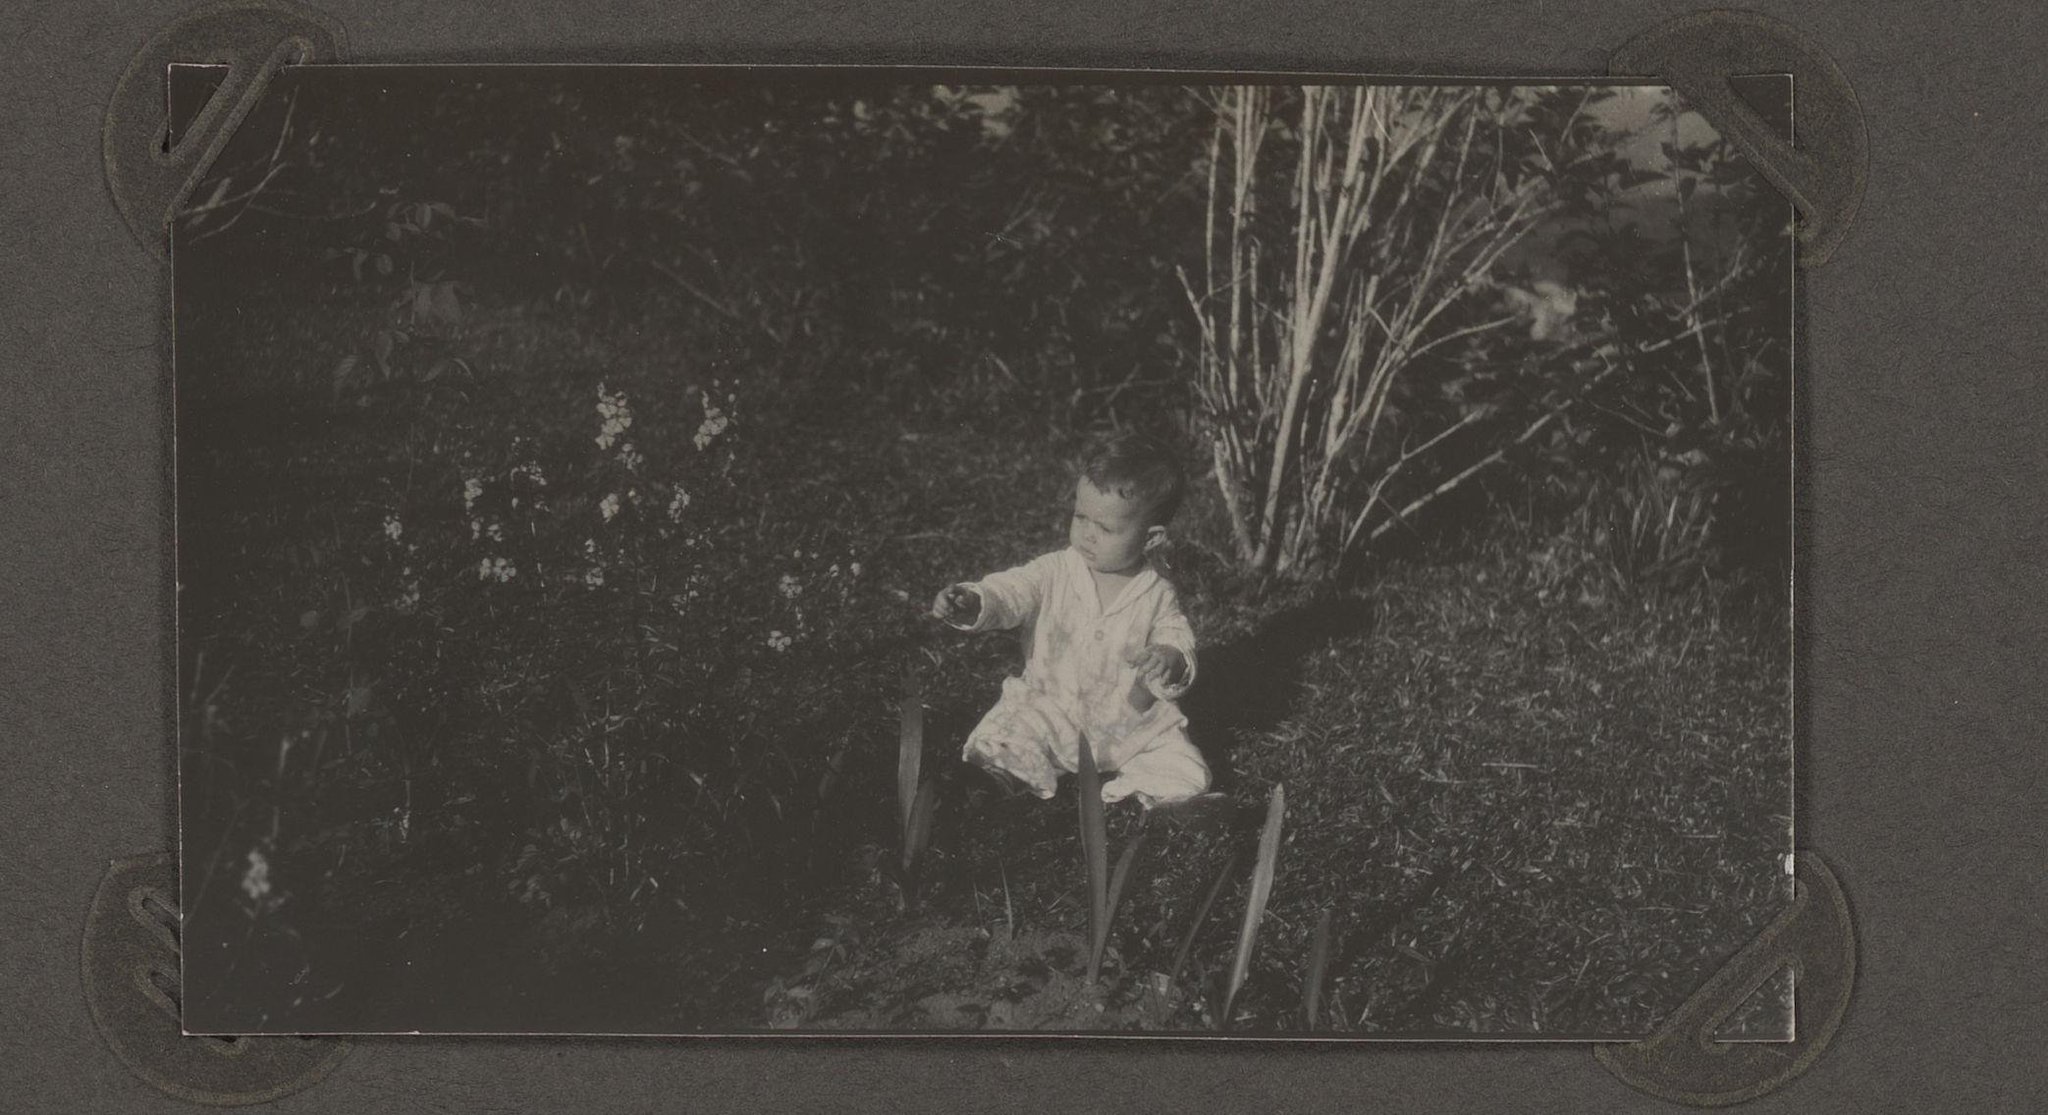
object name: photograph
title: Familiefoto van de kinderen Jetten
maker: Anonymous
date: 1925-1927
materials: photographic support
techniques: photography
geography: suriname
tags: jetten, familie, moengo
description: Familiefoto van de kinderen Jetten. Foto op een bladzijde van een los albumblad. Onderdeel van het ensemble met foto's van de familie van ingenieur Jetten in de mijnbouwstad Moengo in Suriname.